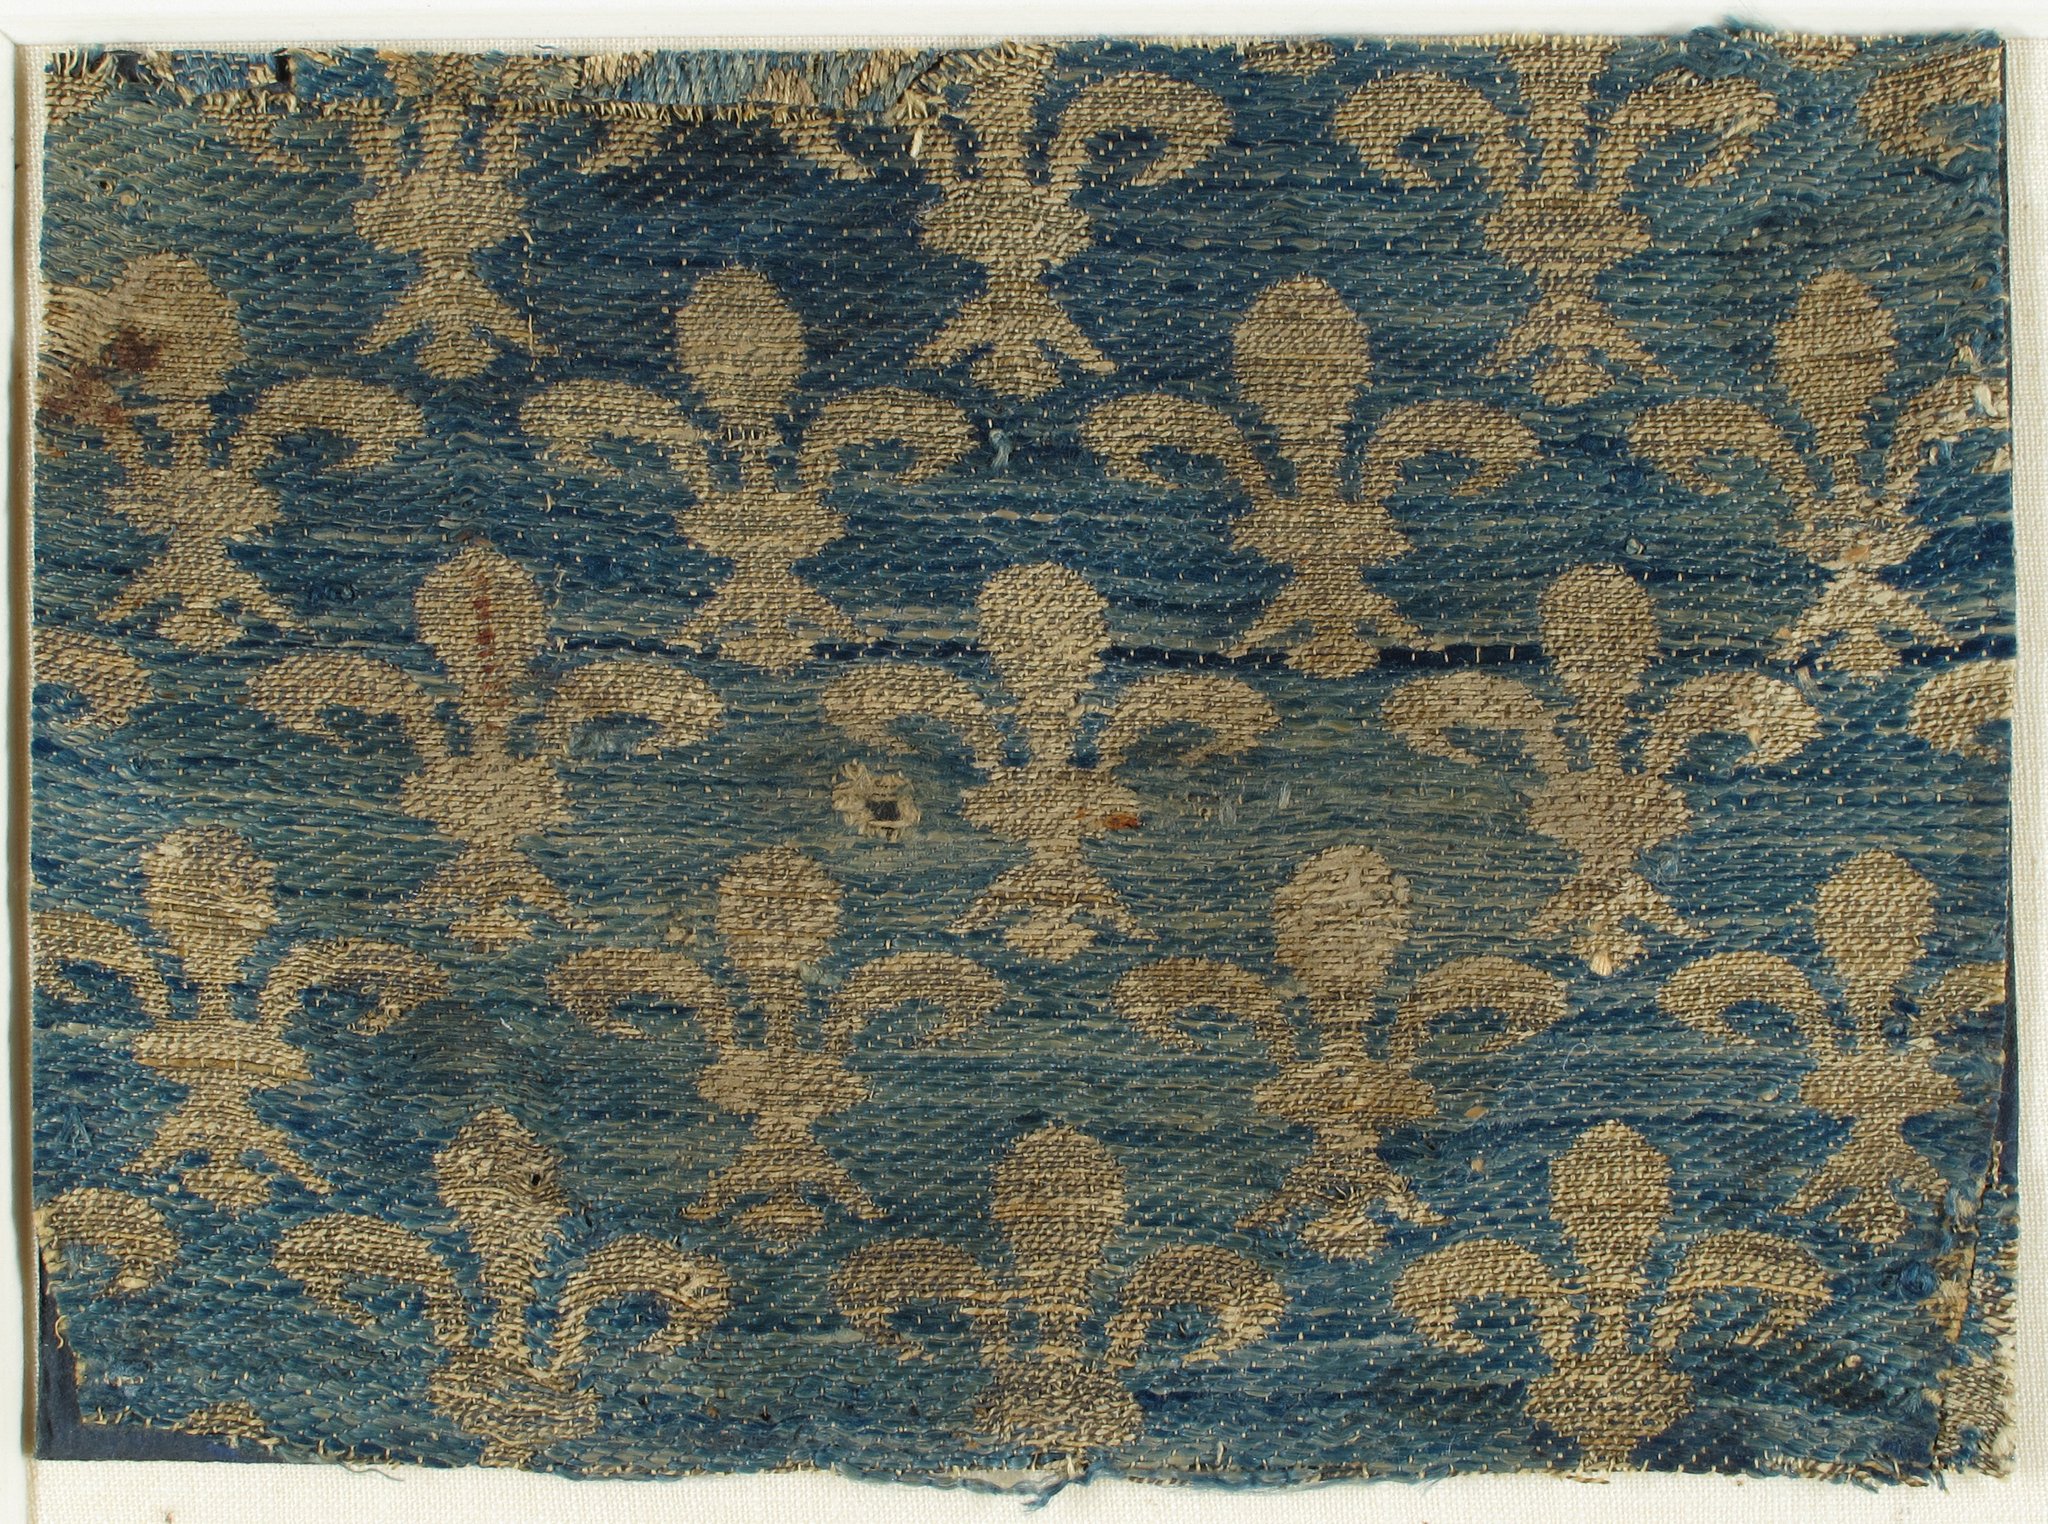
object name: textile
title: Textile with Fleur-De-Lis Motif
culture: italian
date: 1201-1300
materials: metal thread, silk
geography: italy